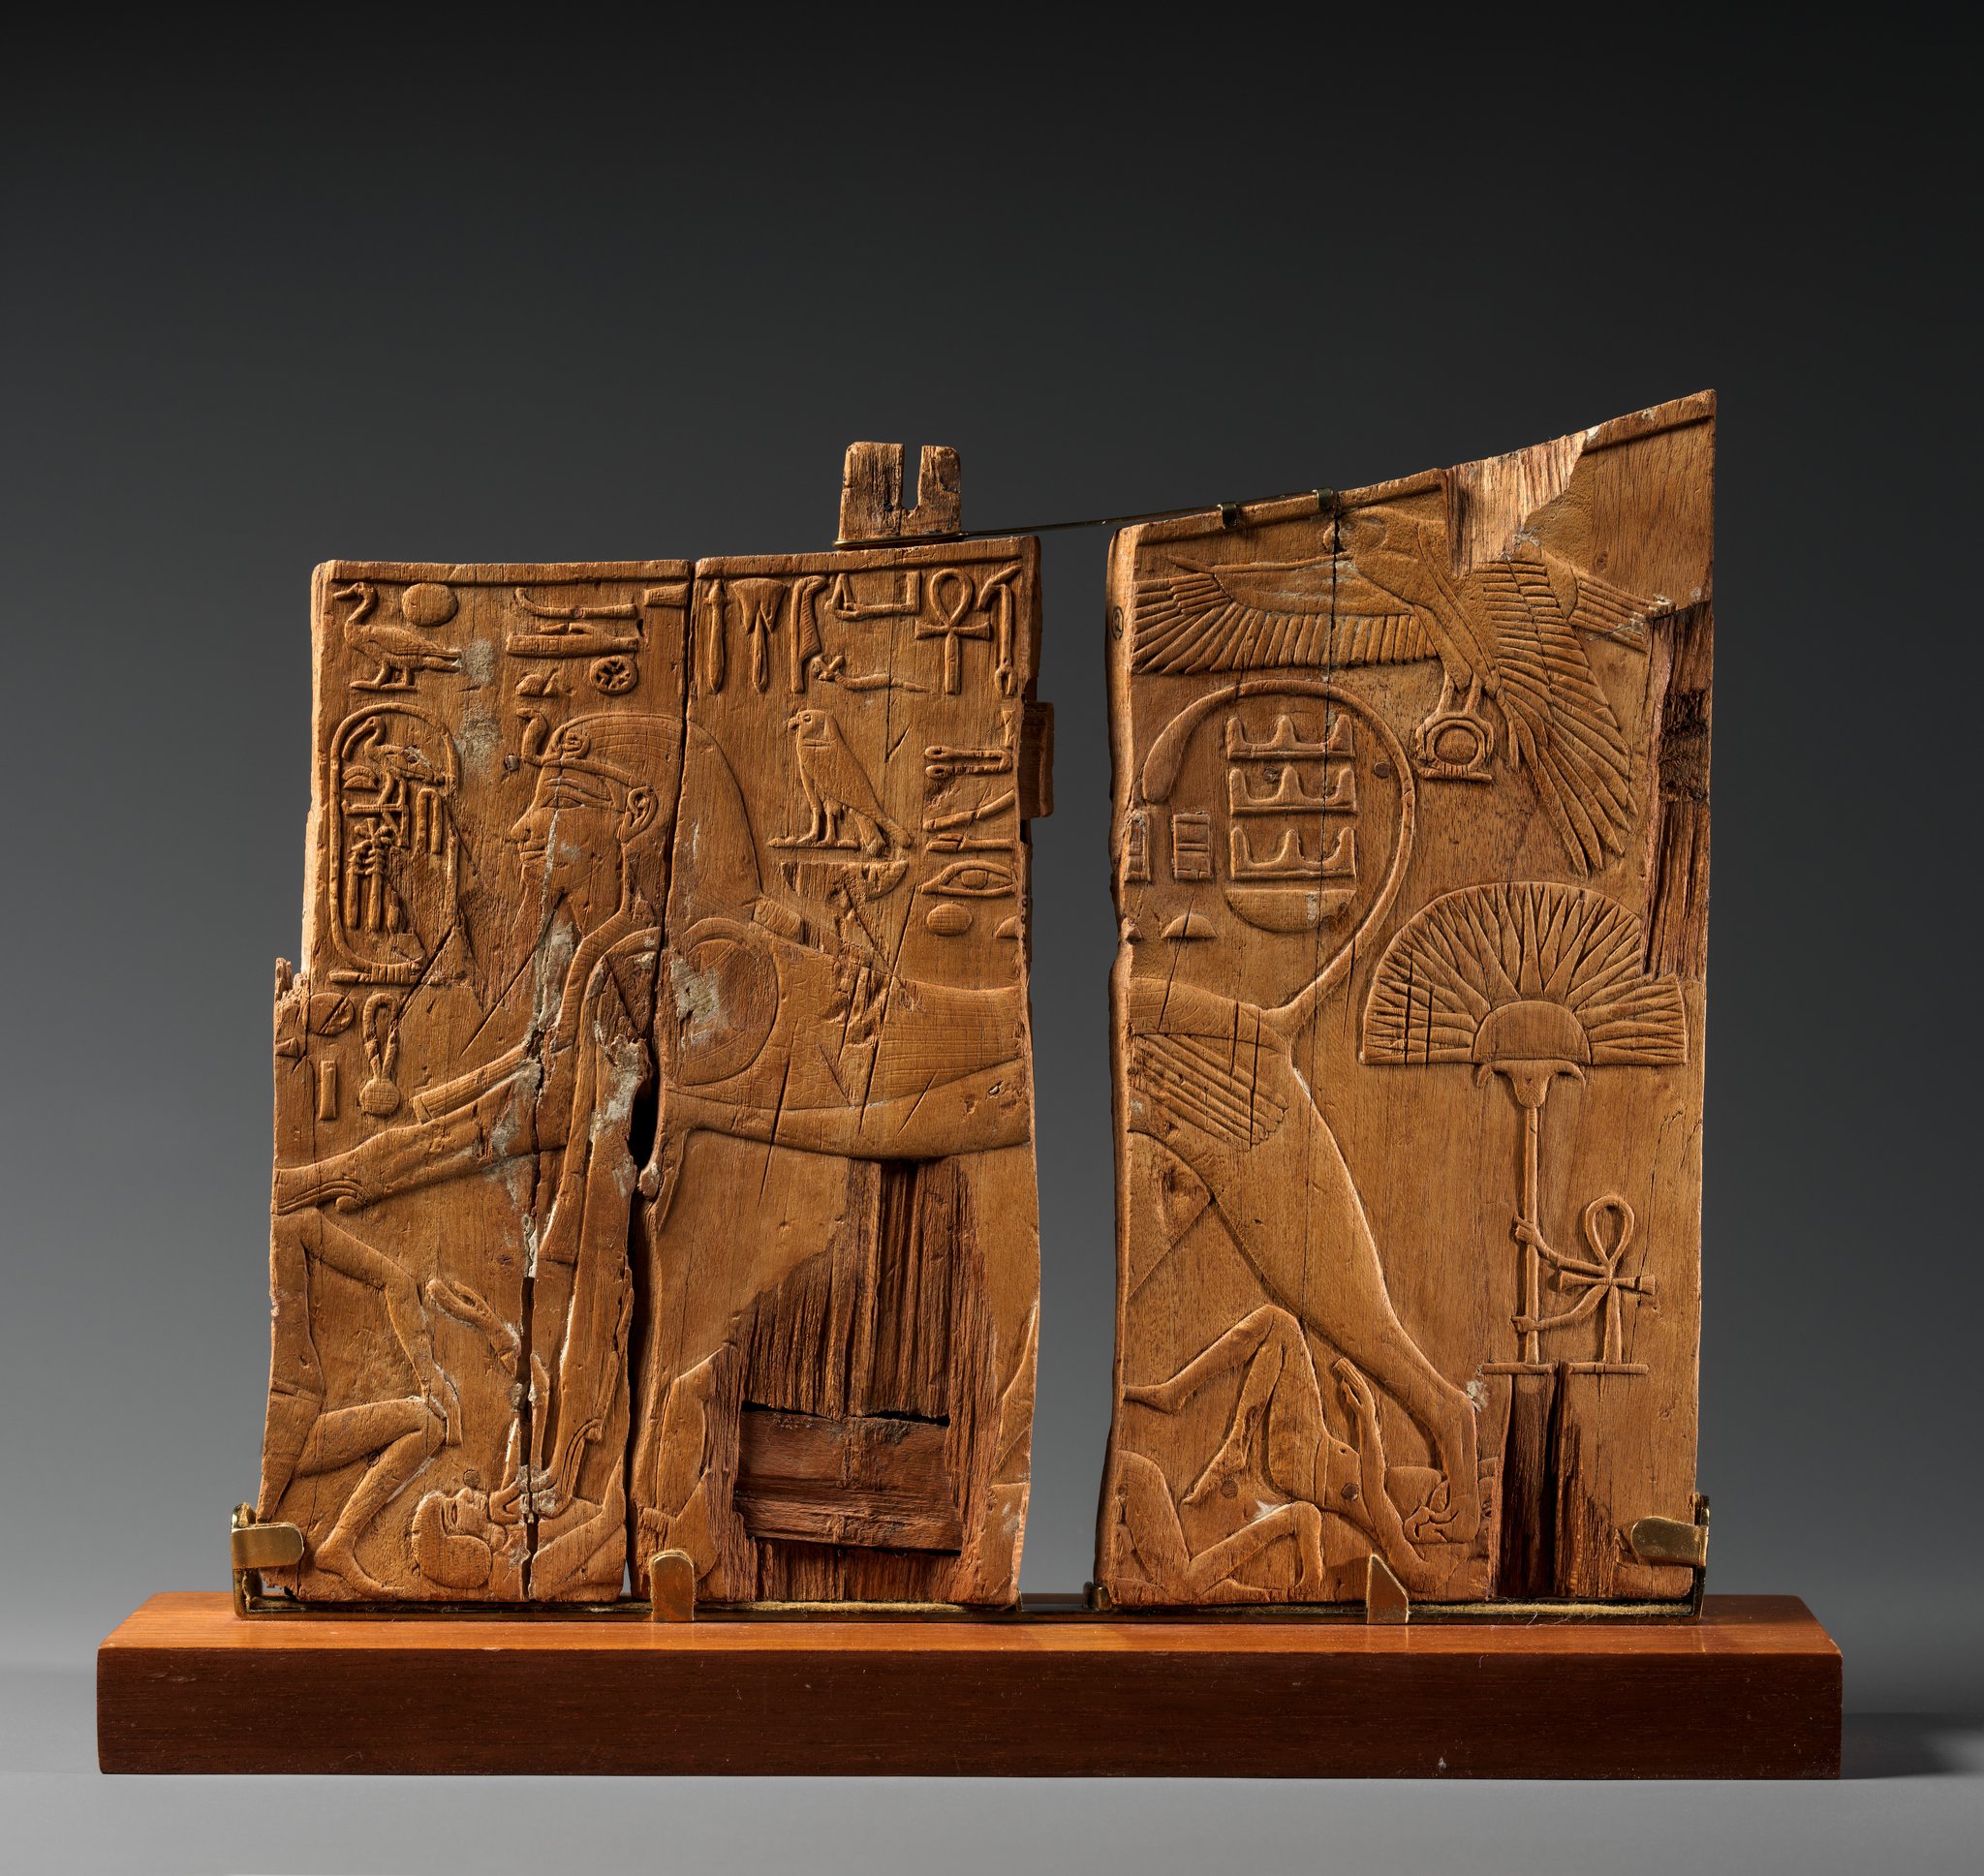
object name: chair, arm panel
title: Arm Panel From a Ceremonial Chair of Thutmose IV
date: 1400-1390 BCE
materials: wood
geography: egypt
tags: falcons,hieroglyphs,sphinx